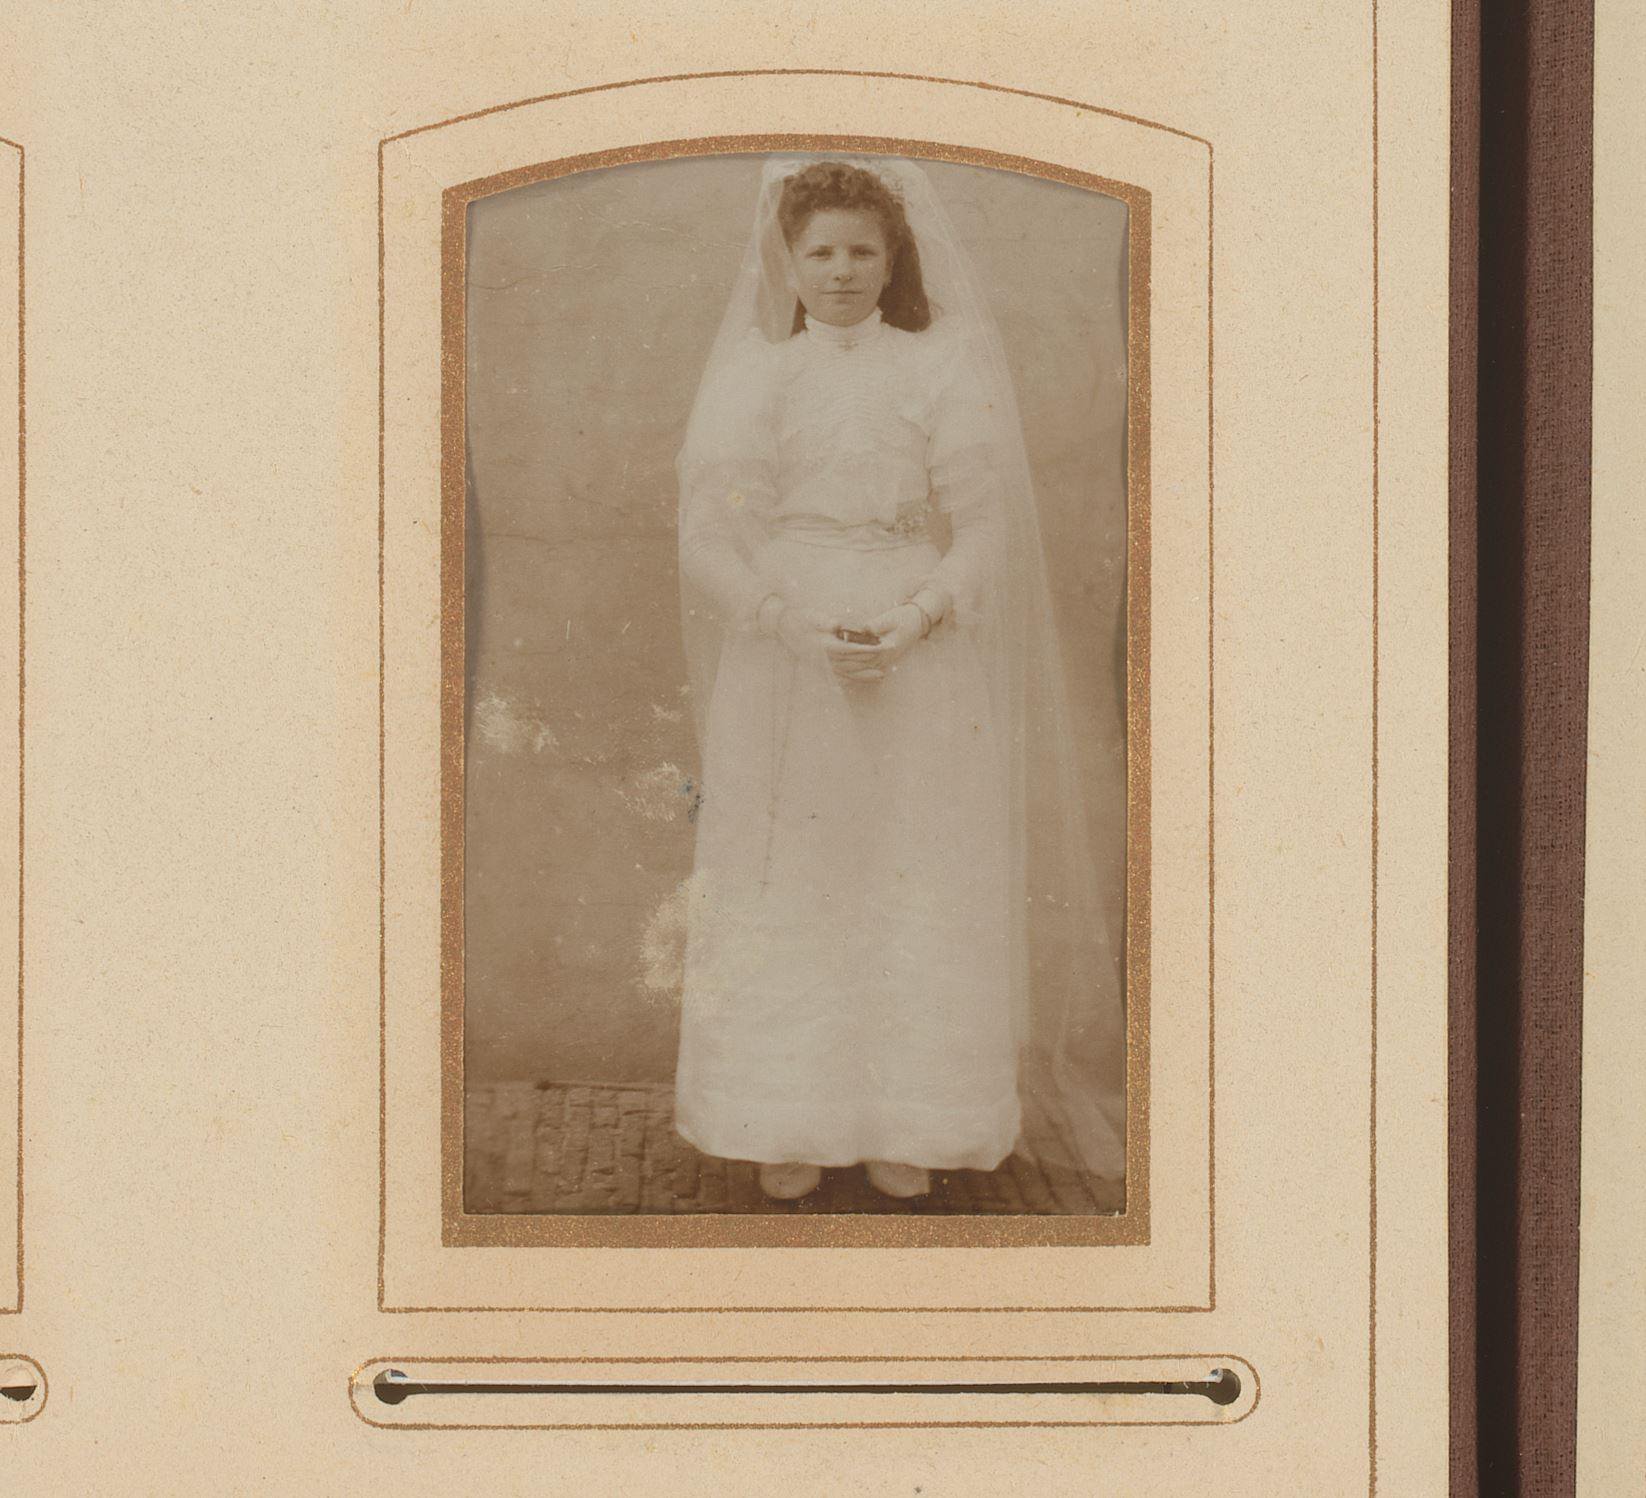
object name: carte de visite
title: Portret van een meisje in een communiejurk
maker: aaron cohen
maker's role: fotograaf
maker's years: 1871-1921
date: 1907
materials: cardboard, photographic support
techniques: collodion silver print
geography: the hague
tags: communion dress, girl (child between toddler and youth)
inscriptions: inscription: ‘A. Cohen/ Waldeck Pyrmontkade 55/ Den Haag’